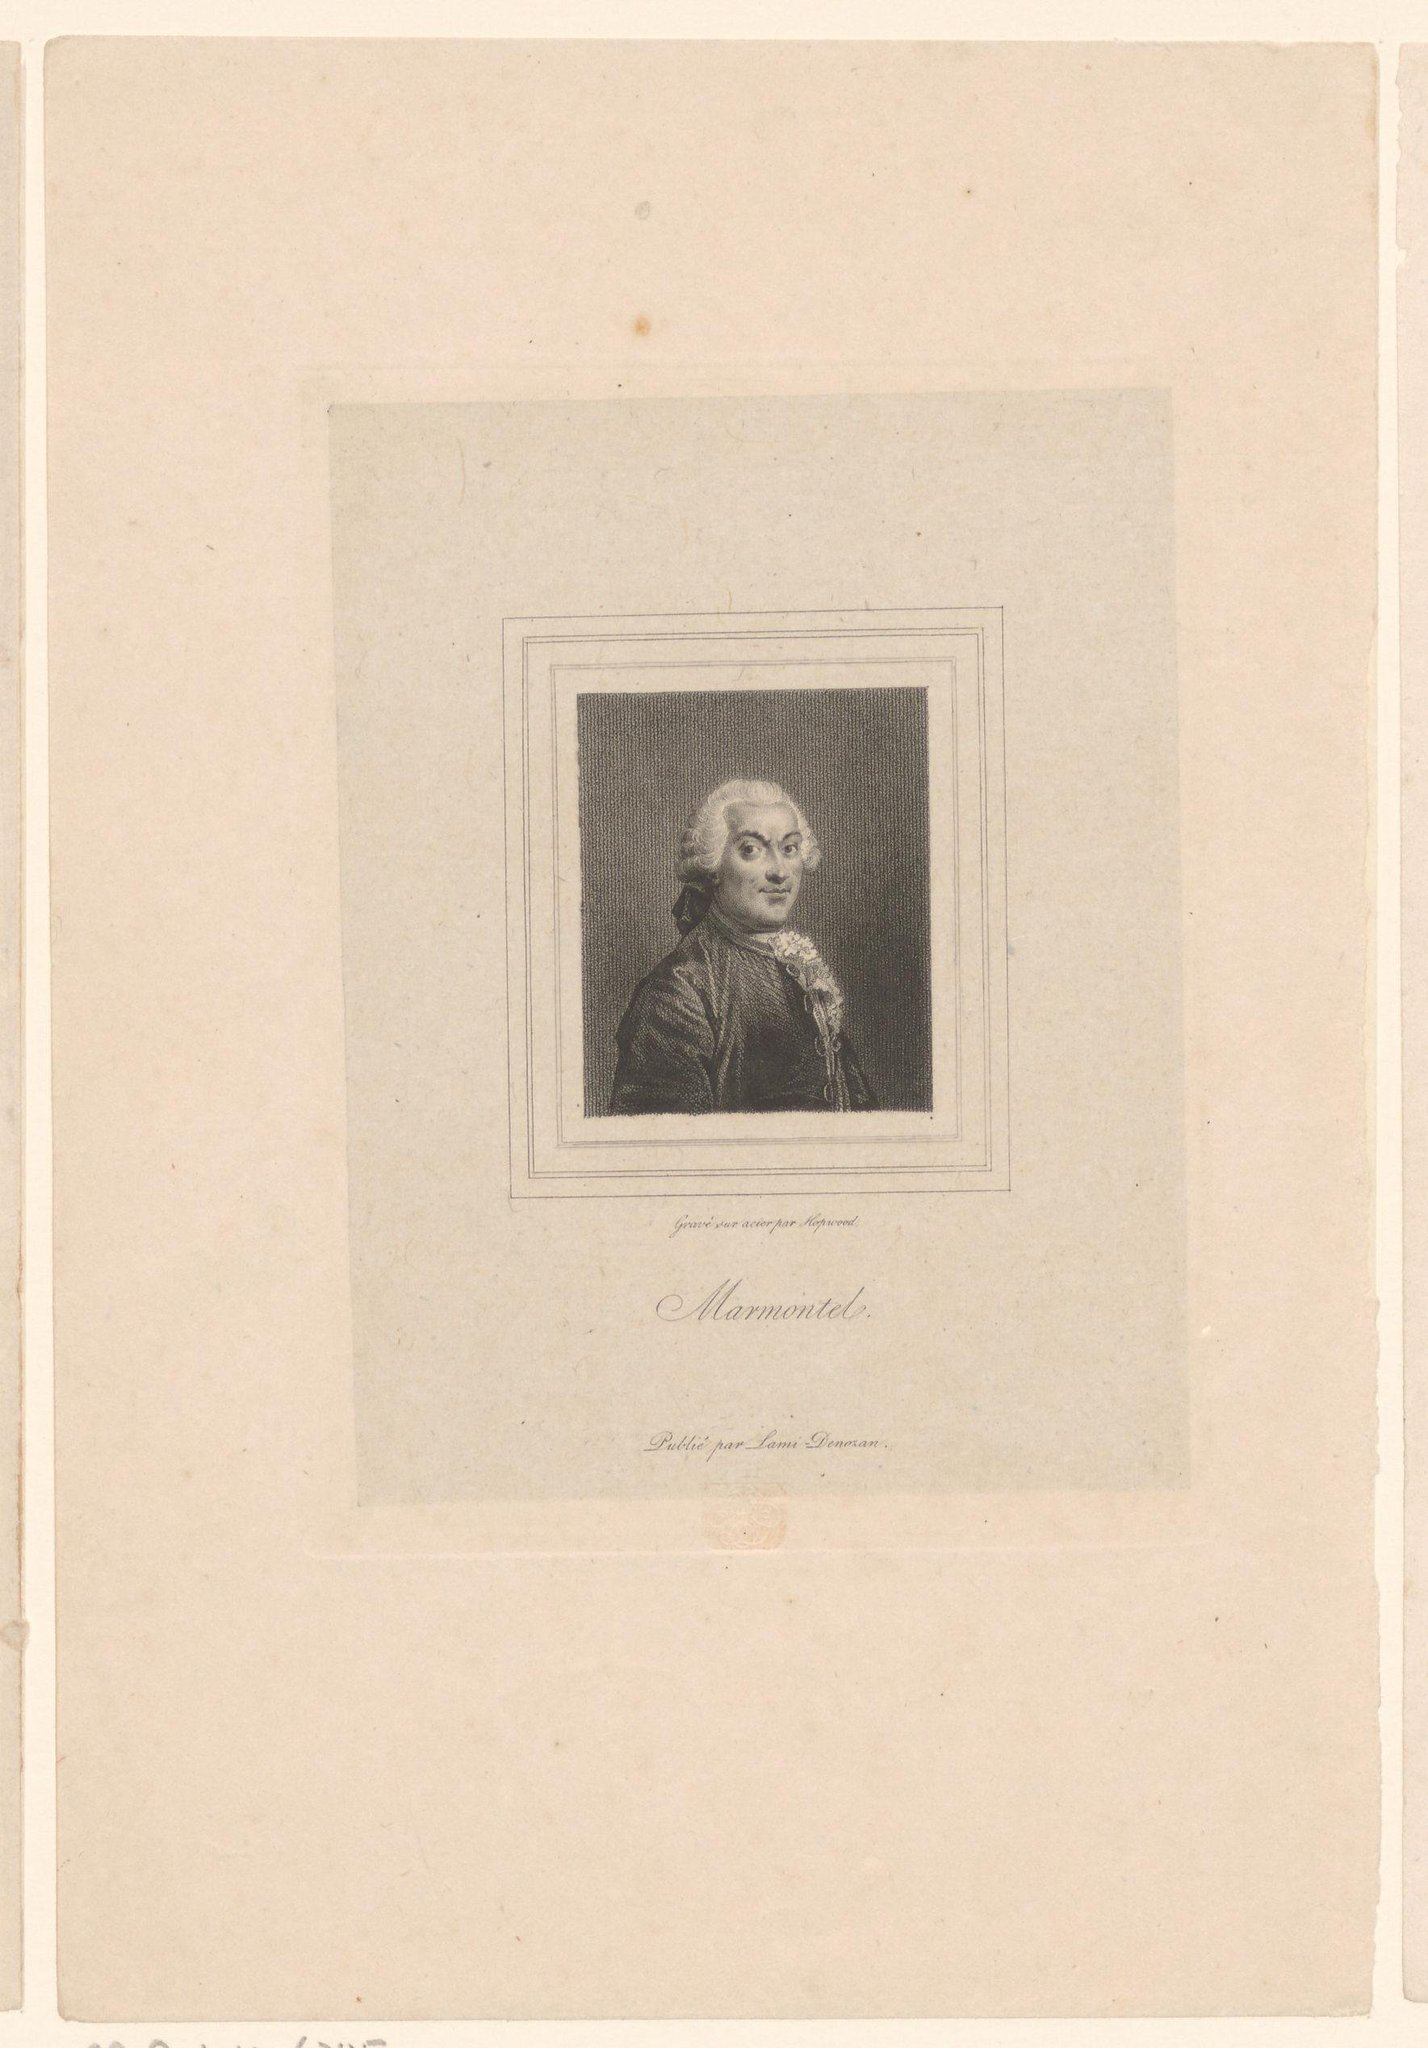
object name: print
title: Portret van Jean-François Marmontel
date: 1828-1850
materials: paper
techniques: etching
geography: paris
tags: jean françois marmontel, historical persons, portrait of a writer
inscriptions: check stamp: ‘A[?]’, collector's mark: Lugt 2228